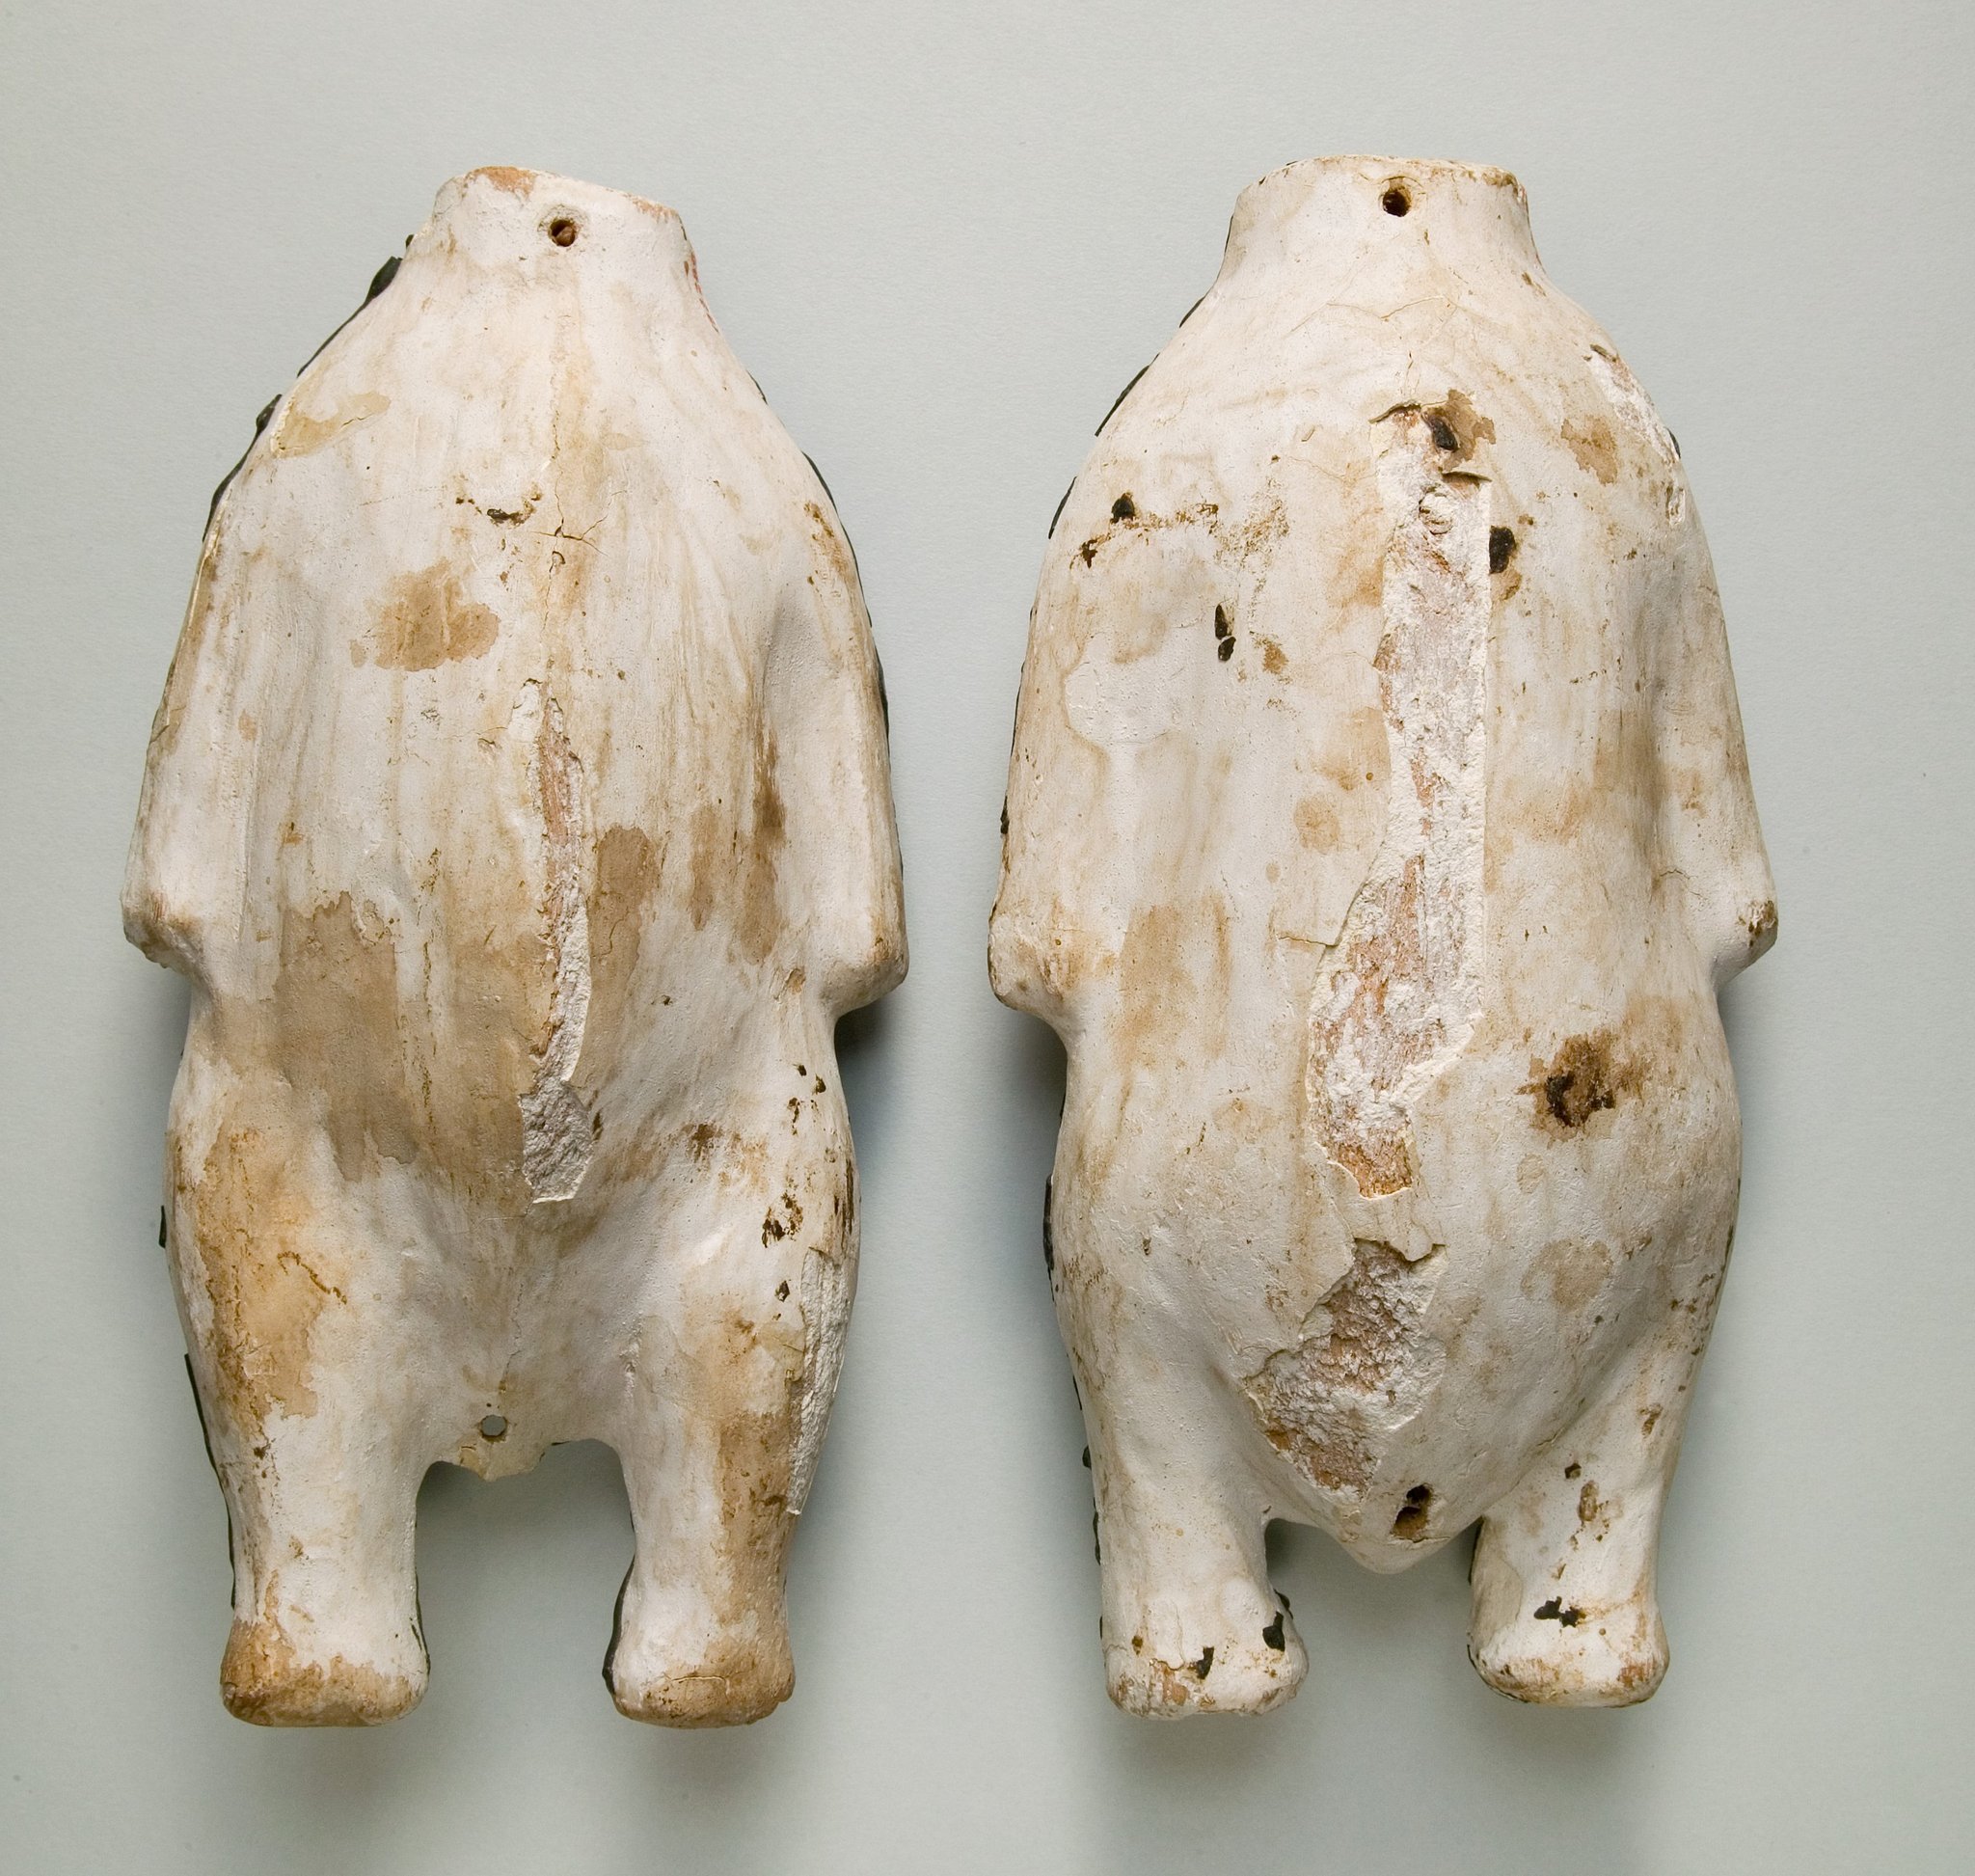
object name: food, case, pigeon, duck, goose, mummy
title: Food Case Probably Containing a Preserved Pigeon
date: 1550-1479 BCE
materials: plaster, wood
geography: egypt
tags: pigeons